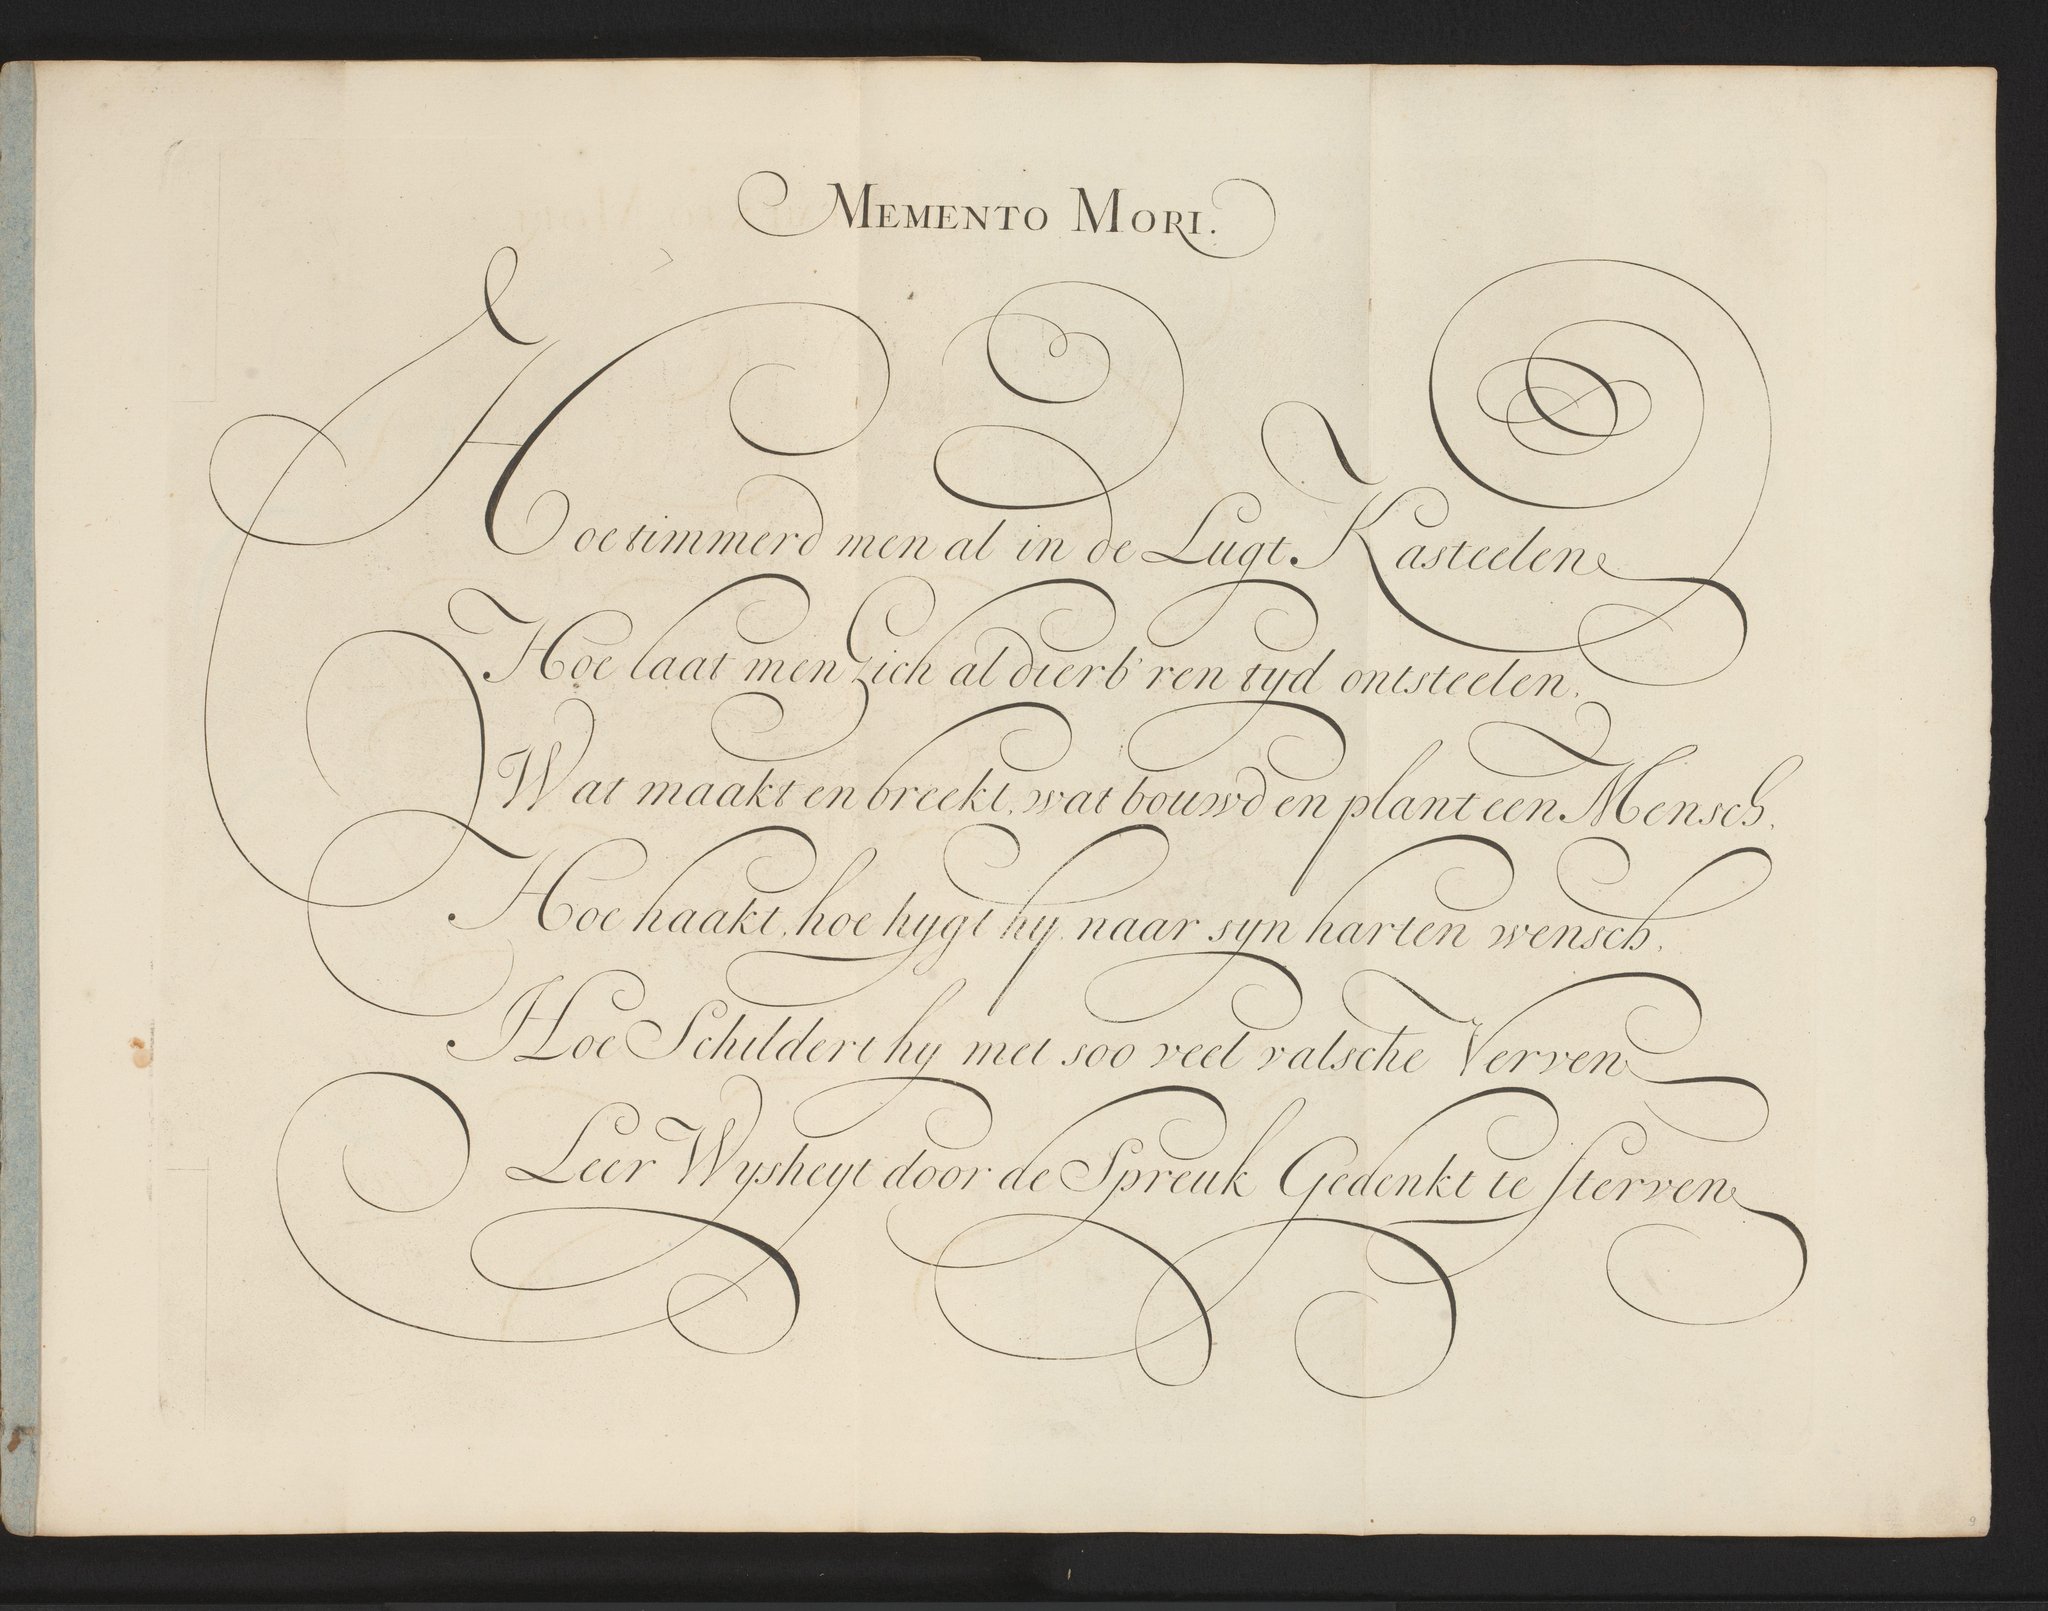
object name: ornament print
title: Schrijfvoorbeeld: Hoe timmerd men al de Lugt Kasteelen (...)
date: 1660-1751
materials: paper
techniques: engraving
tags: calligraphy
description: Schrijfvoorbeeld met zes regels tekst in het Nederlands: Hoe timmerd men al de Lugt Kasteelen ..., en de titel: Memento Mori. De prent maakt deel uit van een album